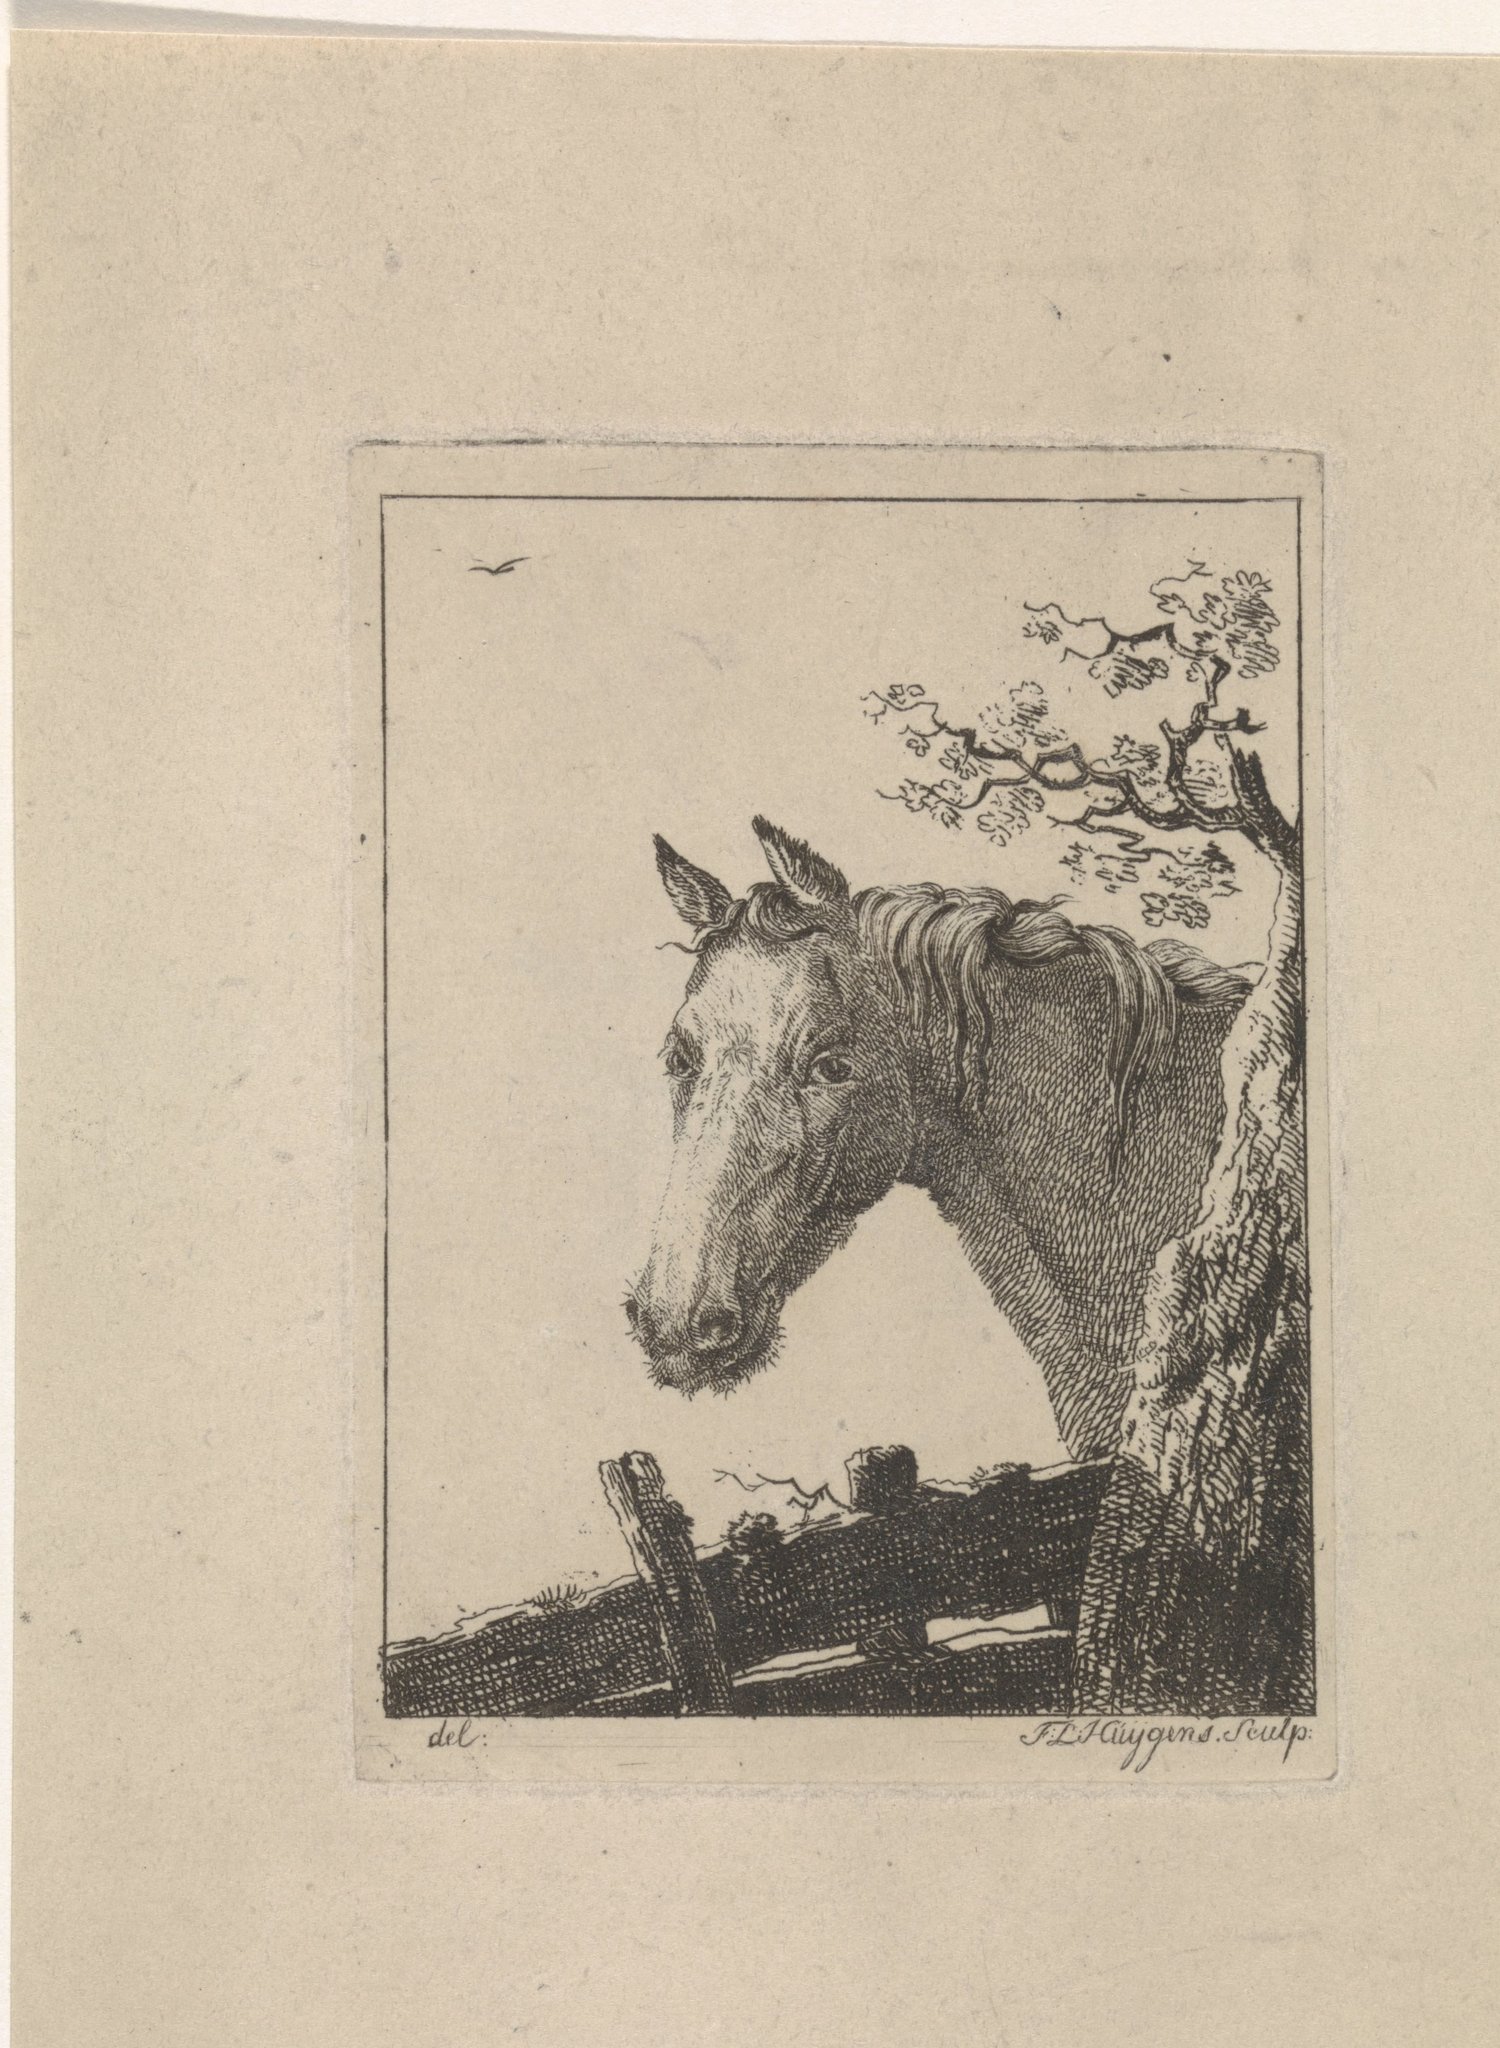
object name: print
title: Hoofd van een paard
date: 1817-1887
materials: paper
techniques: engraving, etching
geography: netherlands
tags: horse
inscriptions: collector's mark: Lugt 2228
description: Hoofd van een paard naar links. Rechts een boom, onder de bovenkant van een hek.